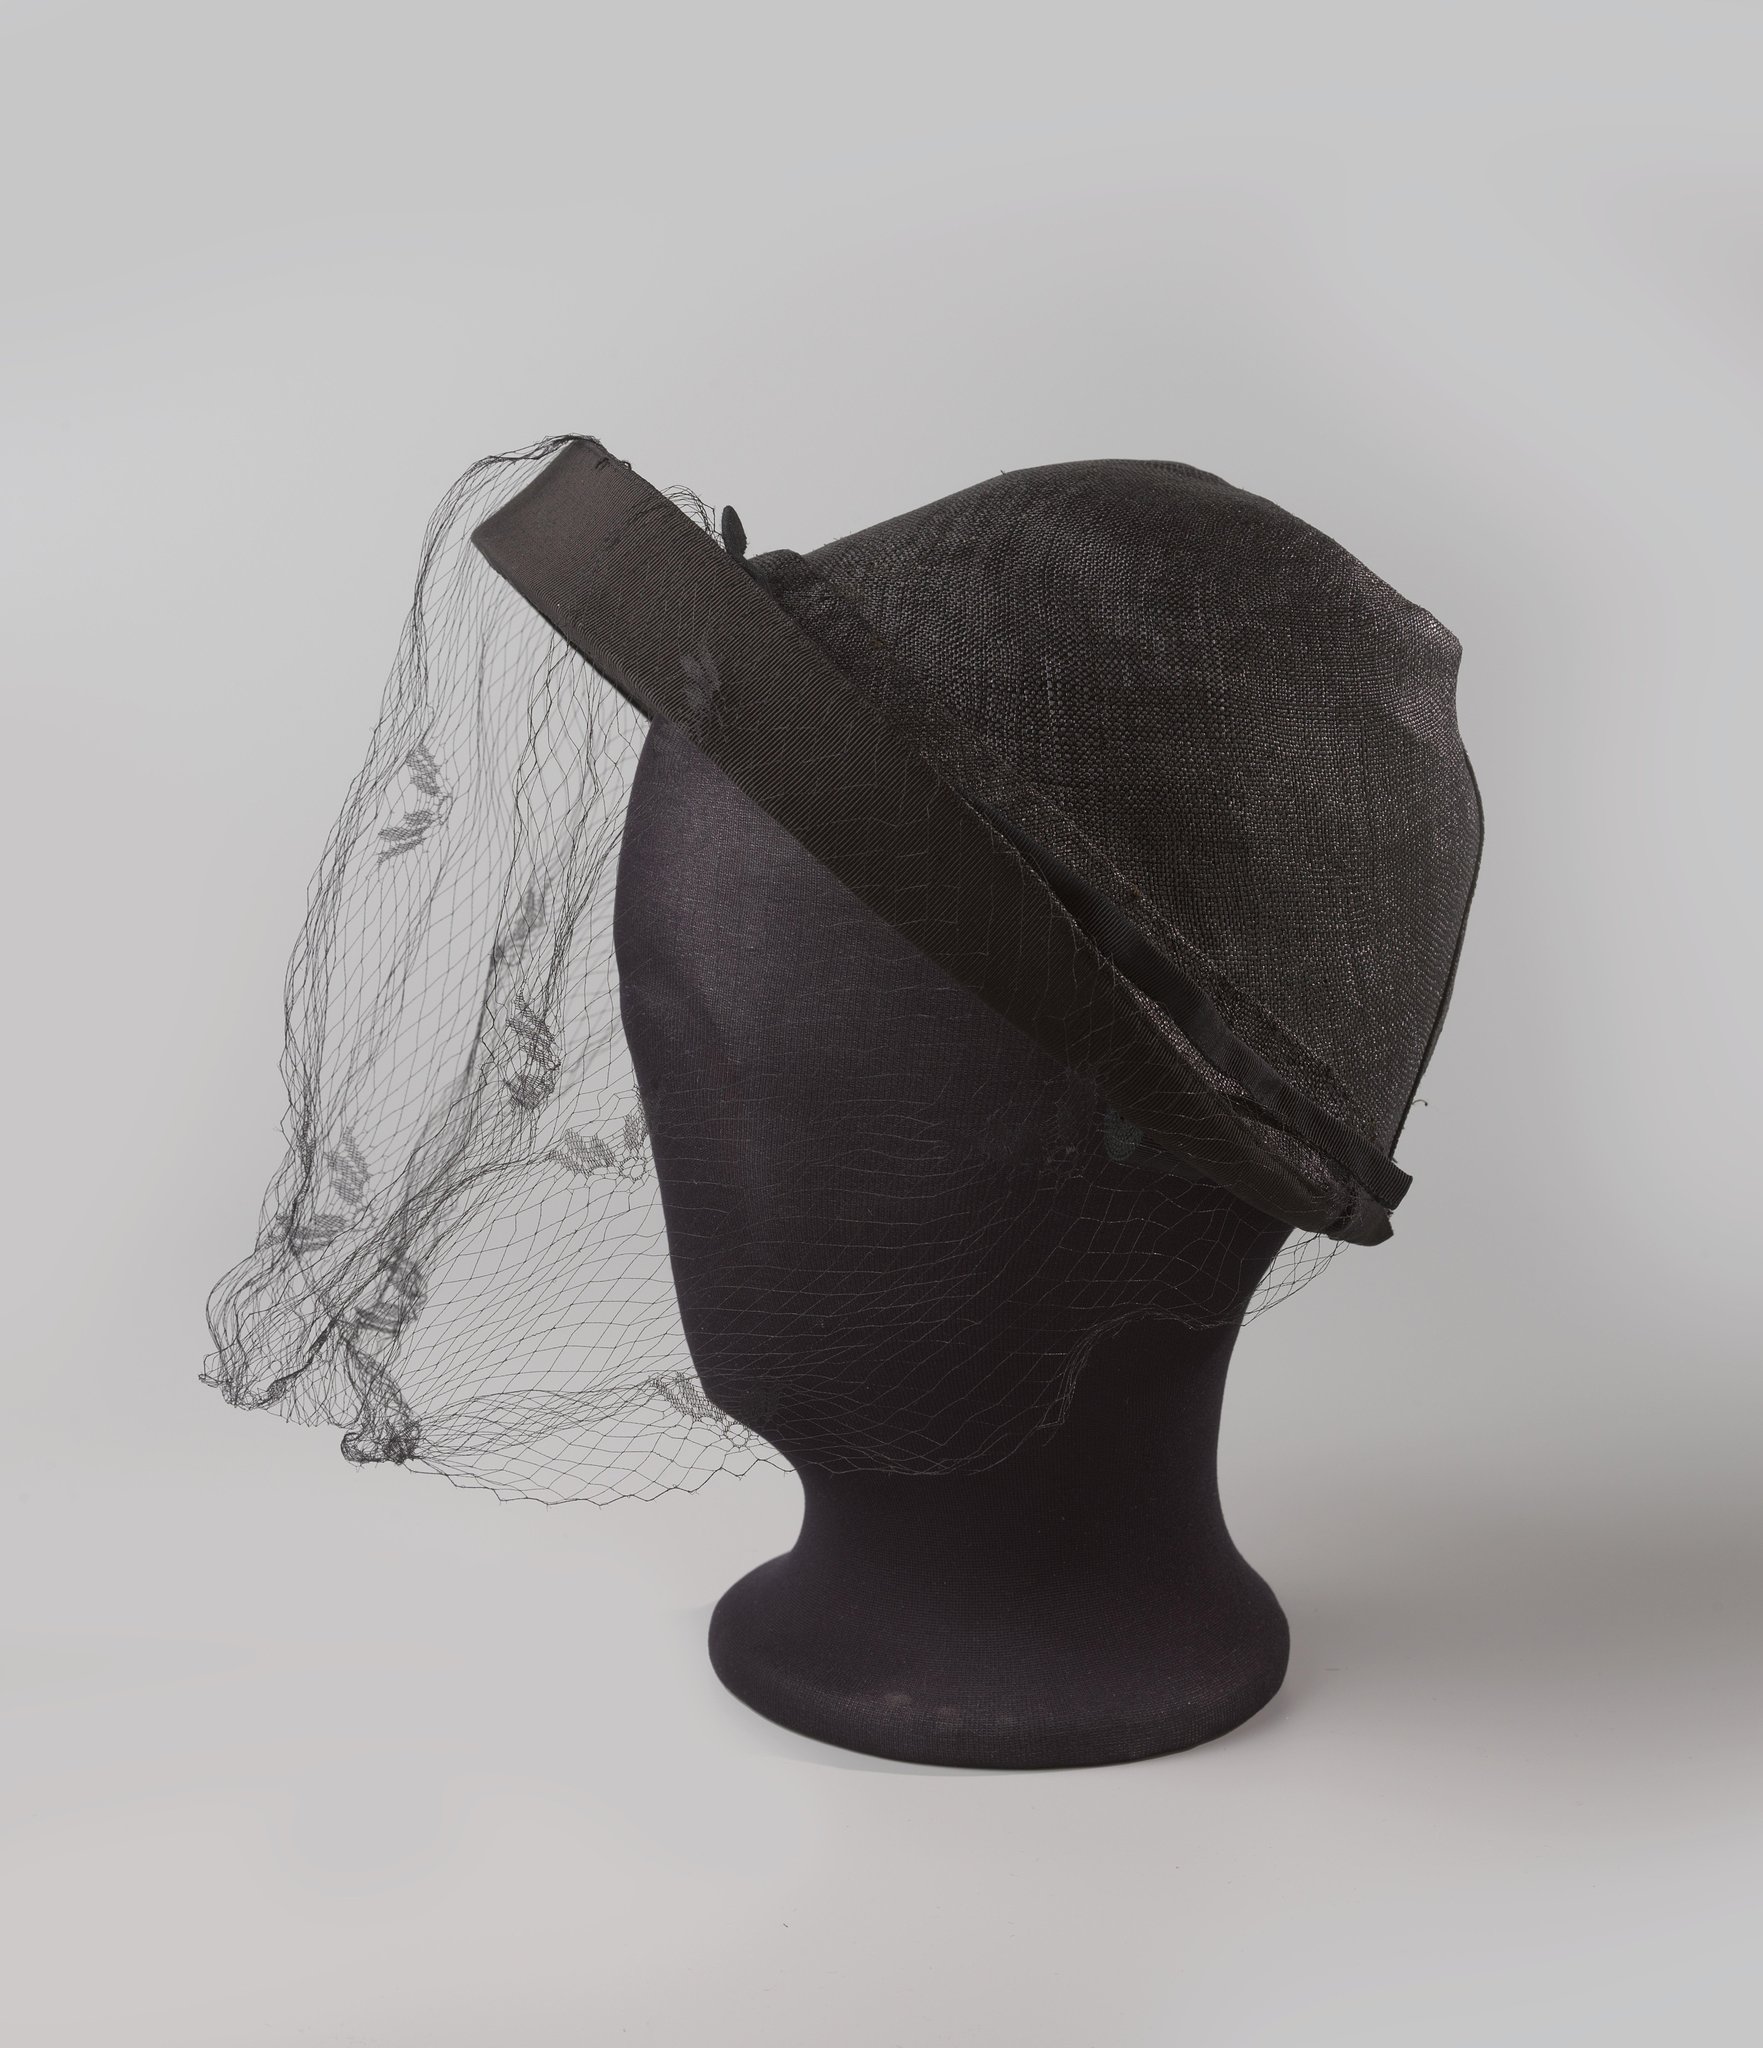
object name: womenswear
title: Hoed van zwarte sisal en grosgrain, met losse voile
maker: Anonymous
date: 1938-1945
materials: fiber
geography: netherlands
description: Hoed van zwarte sisal en grosgrain. Kapothoed met 'geknoopte' kruin. Met twee kinnebanden en een losse voile.